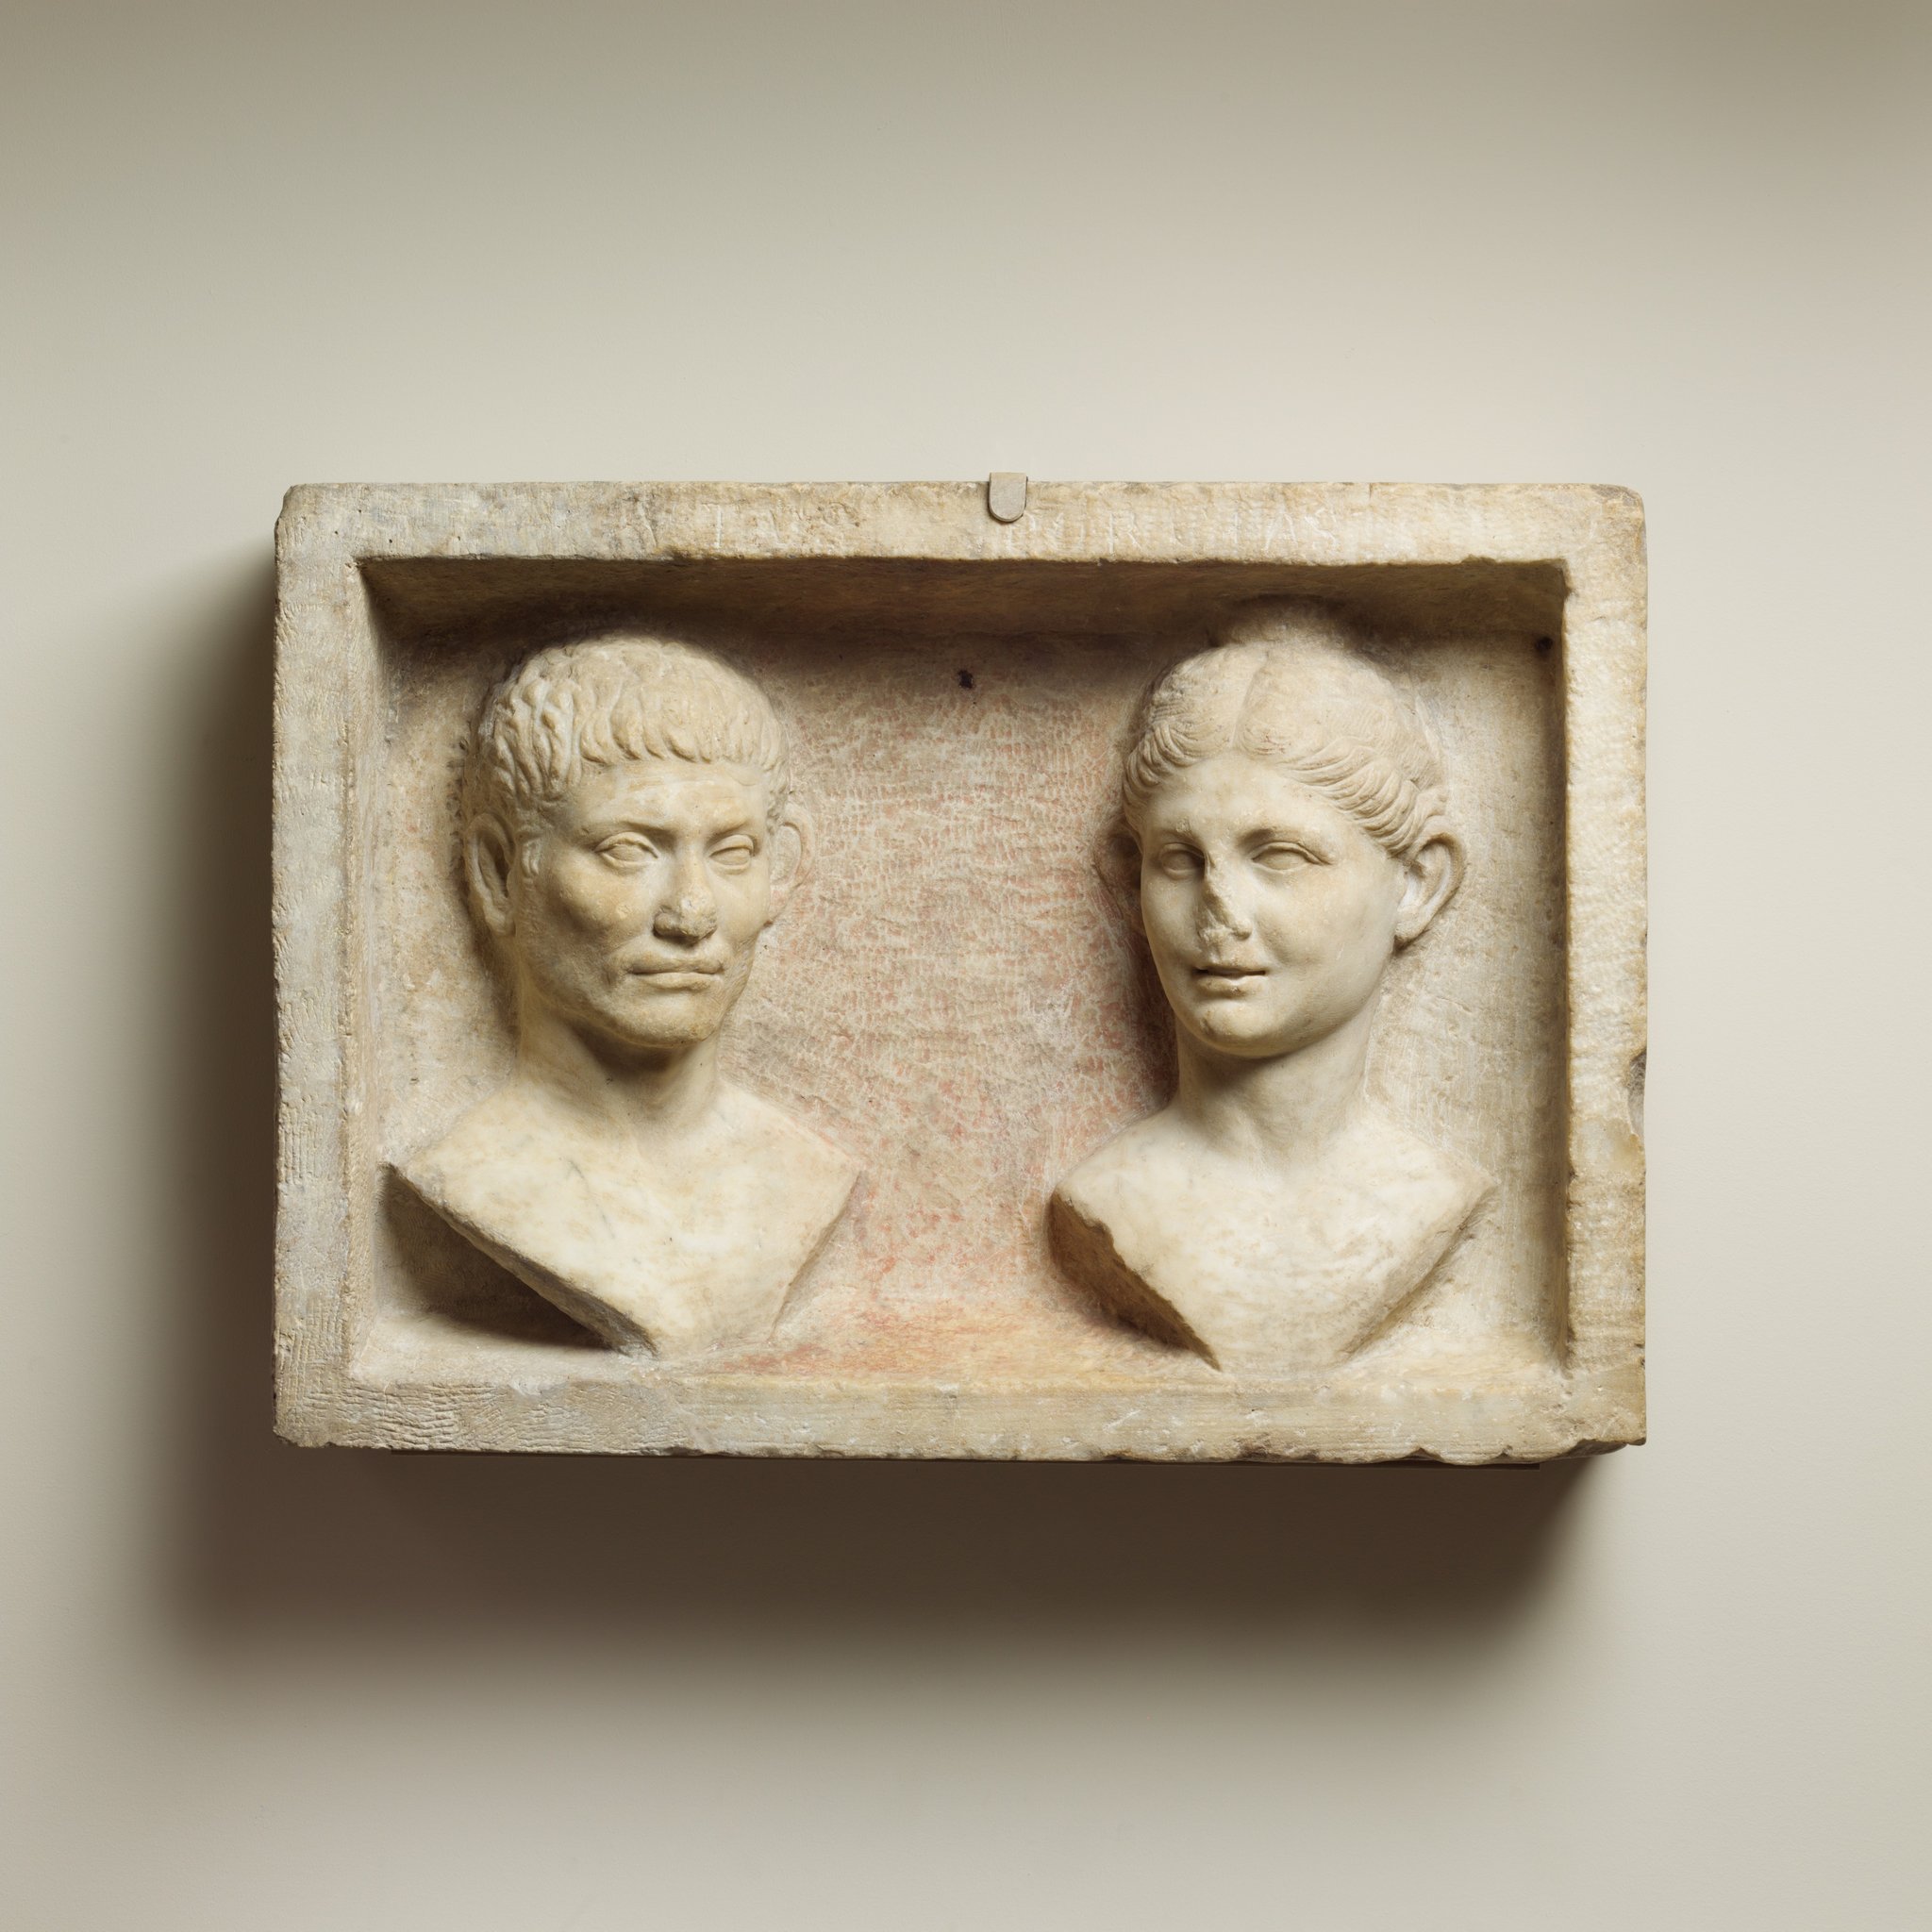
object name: grave relief fragment, two portrait bust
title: Marble grave relief with two portrait busts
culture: roman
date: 13 BCE-5 CE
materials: marble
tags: couples,men,women